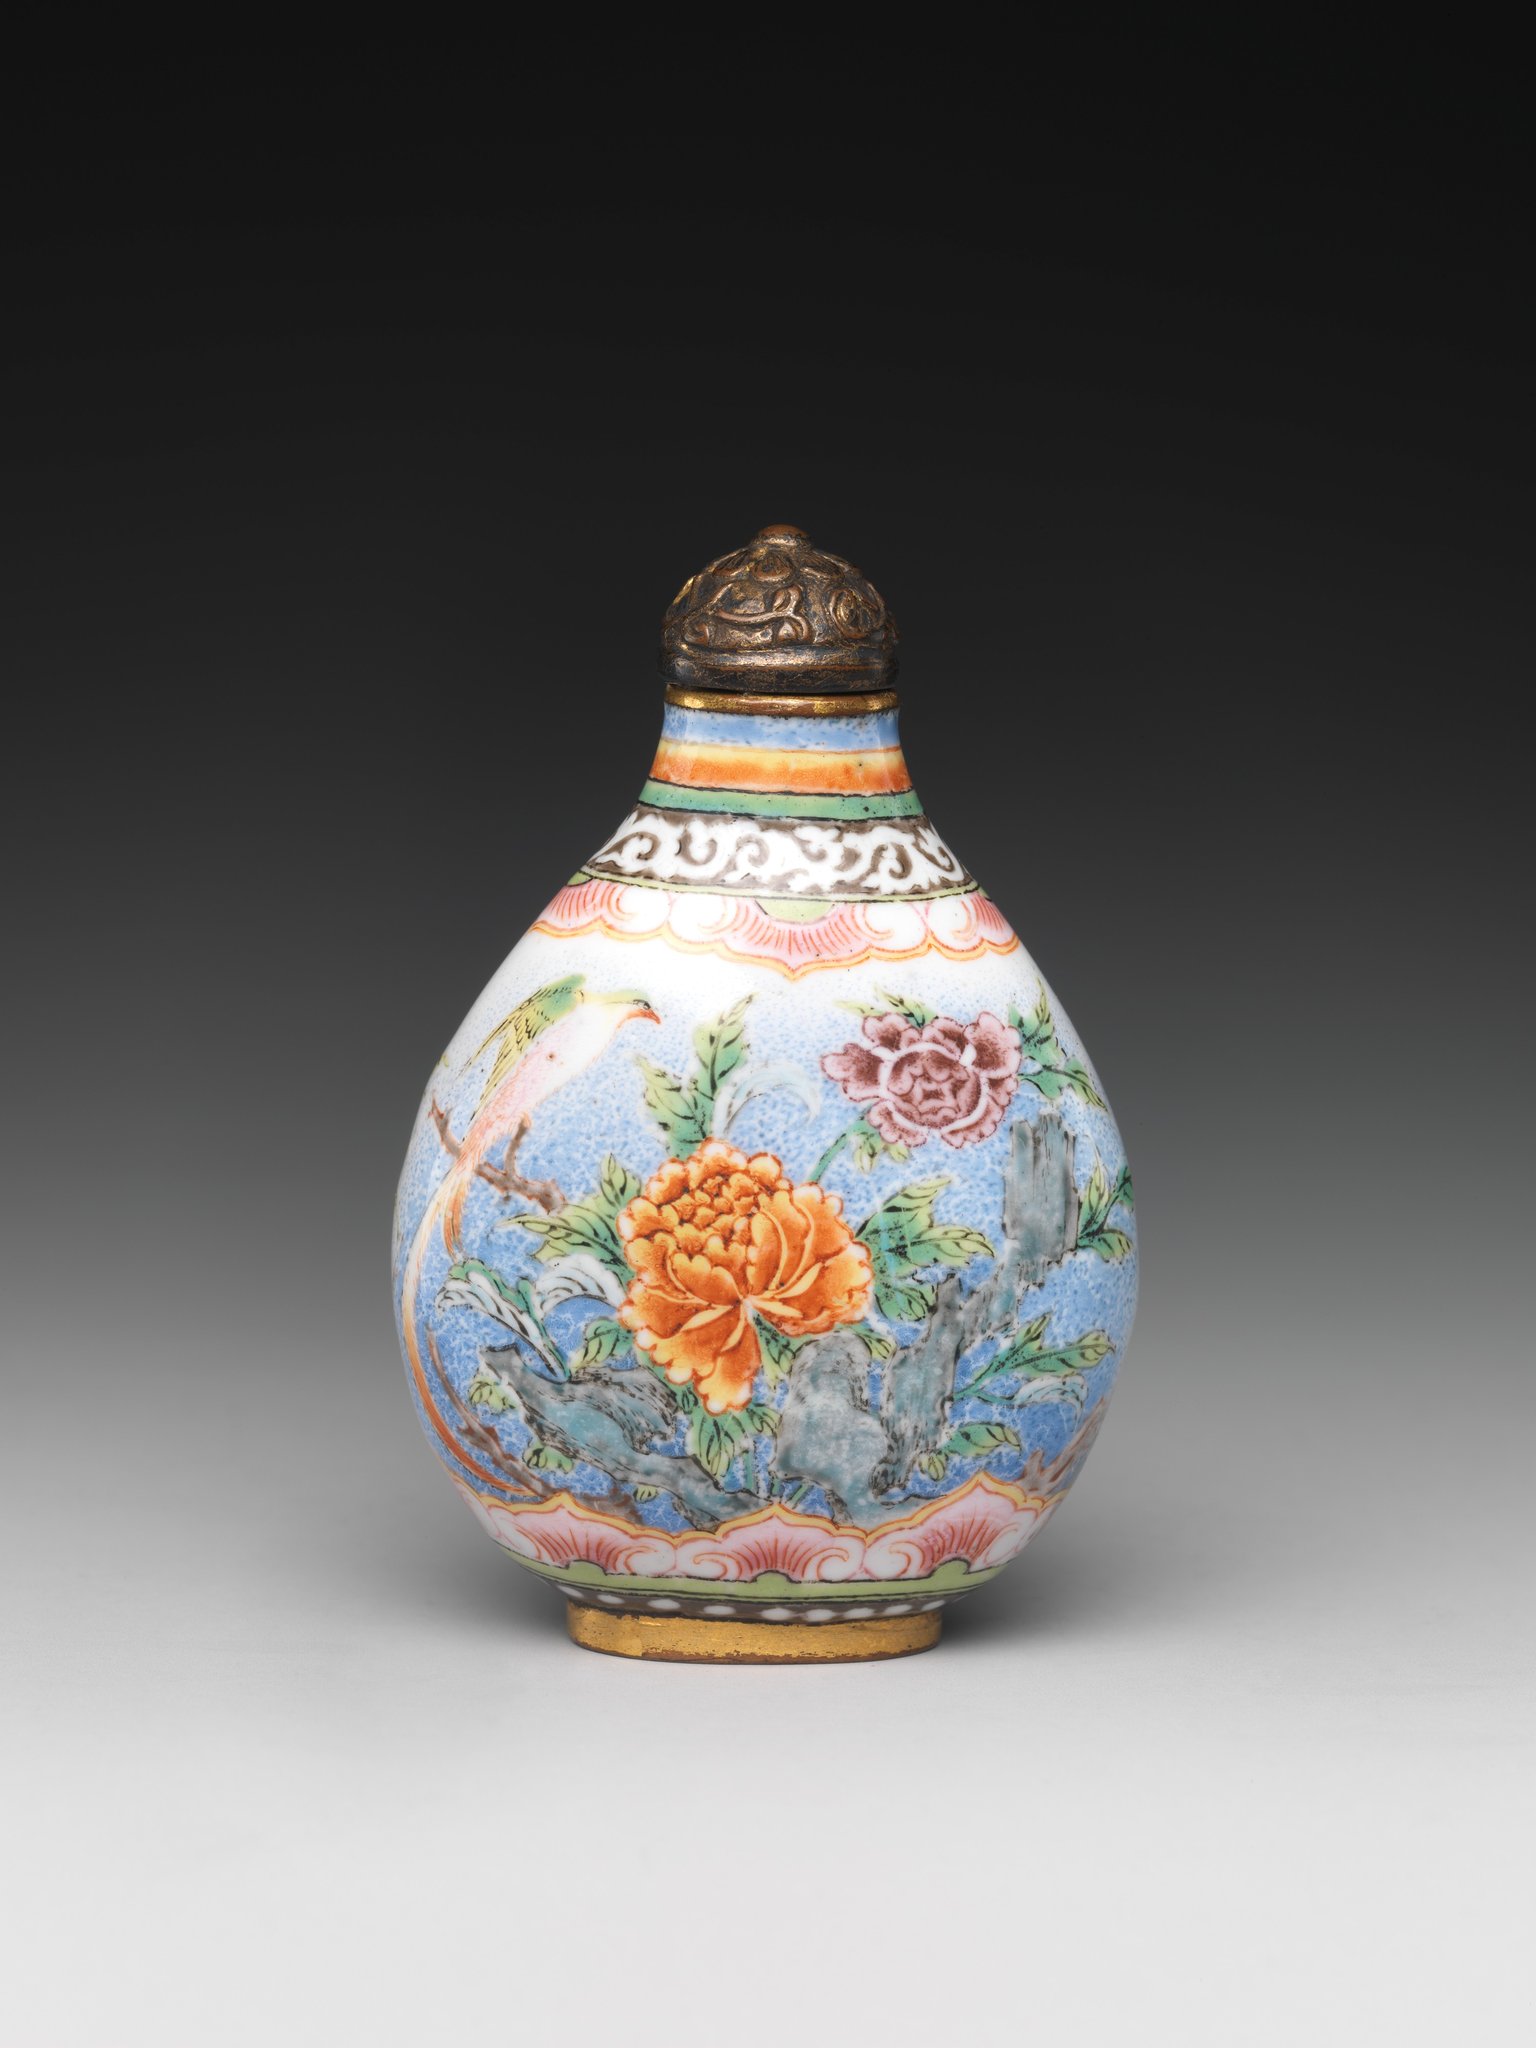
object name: snuff bottle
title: Snuff Bottle with Peony and Bird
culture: chinese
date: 1736-1795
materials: copper, enamel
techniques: painting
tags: birds,peonies